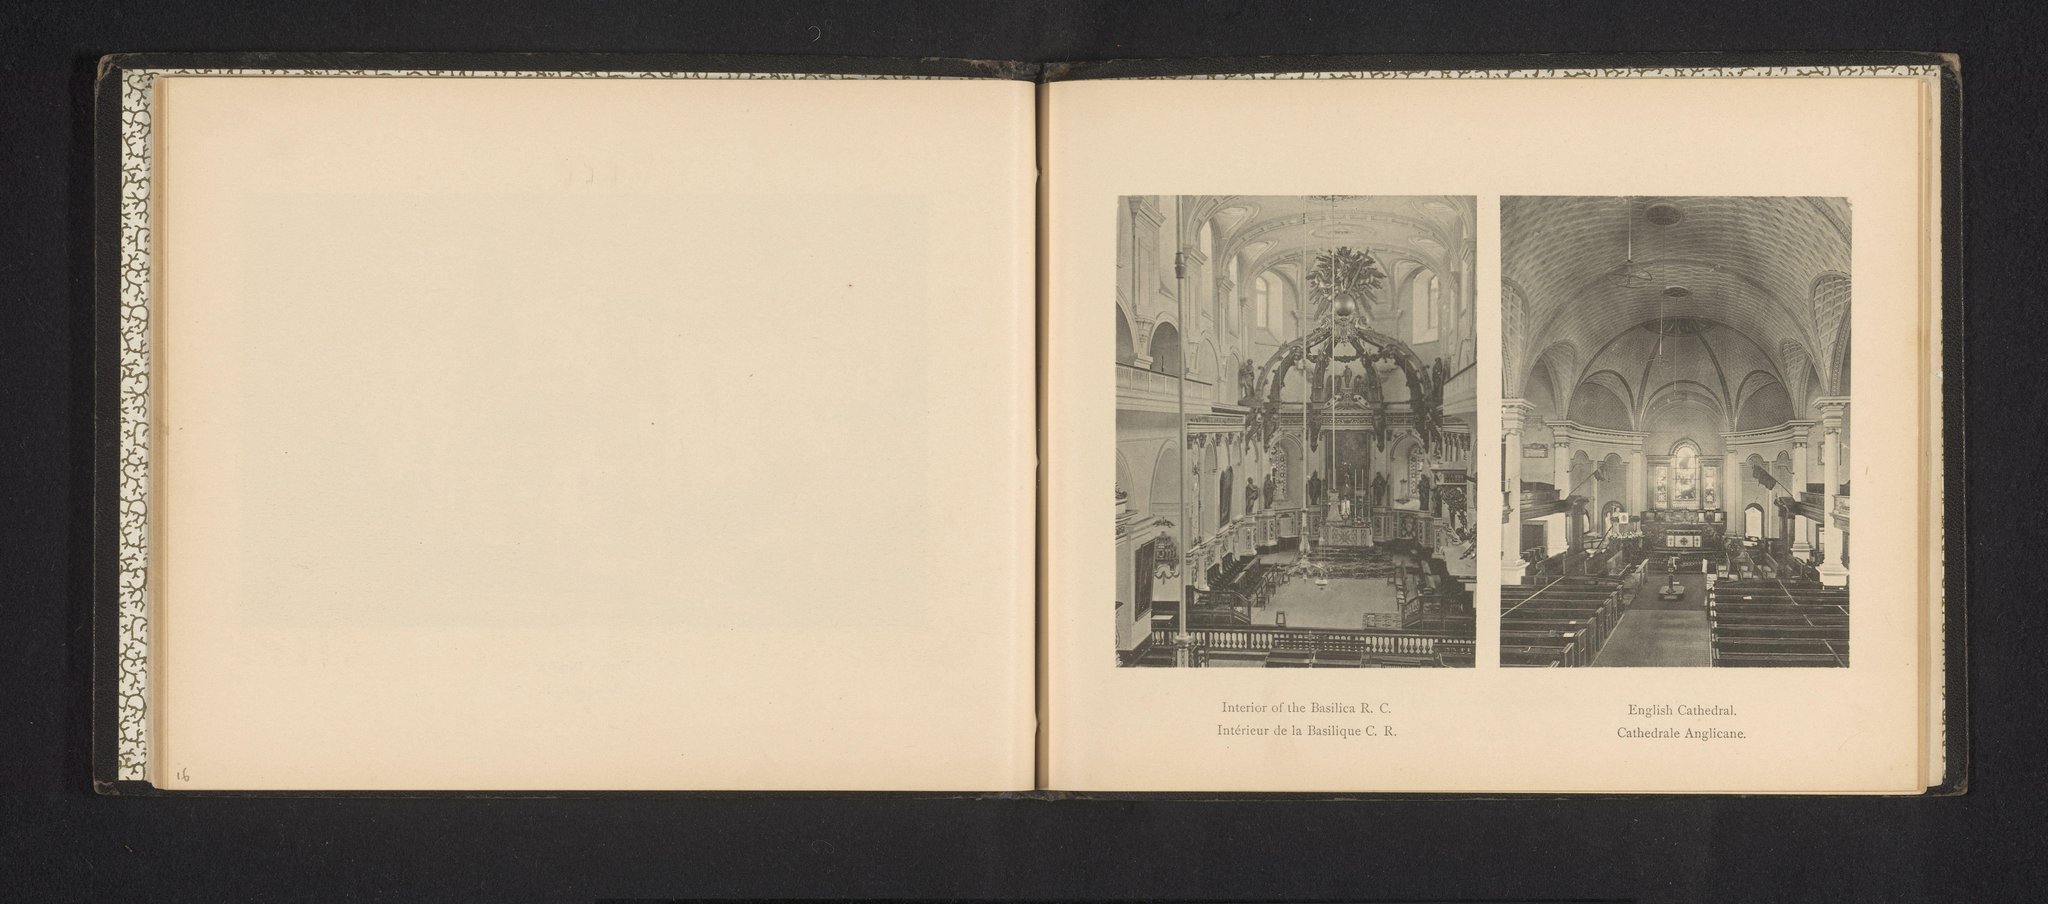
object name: photomechanical print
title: Interieur van de Notre-Dame de Québec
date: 1889-1894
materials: paper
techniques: photograph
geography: quebec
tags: interior of church, québec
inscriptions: inscription: ‘Intérieur de la Basilique C. R.’